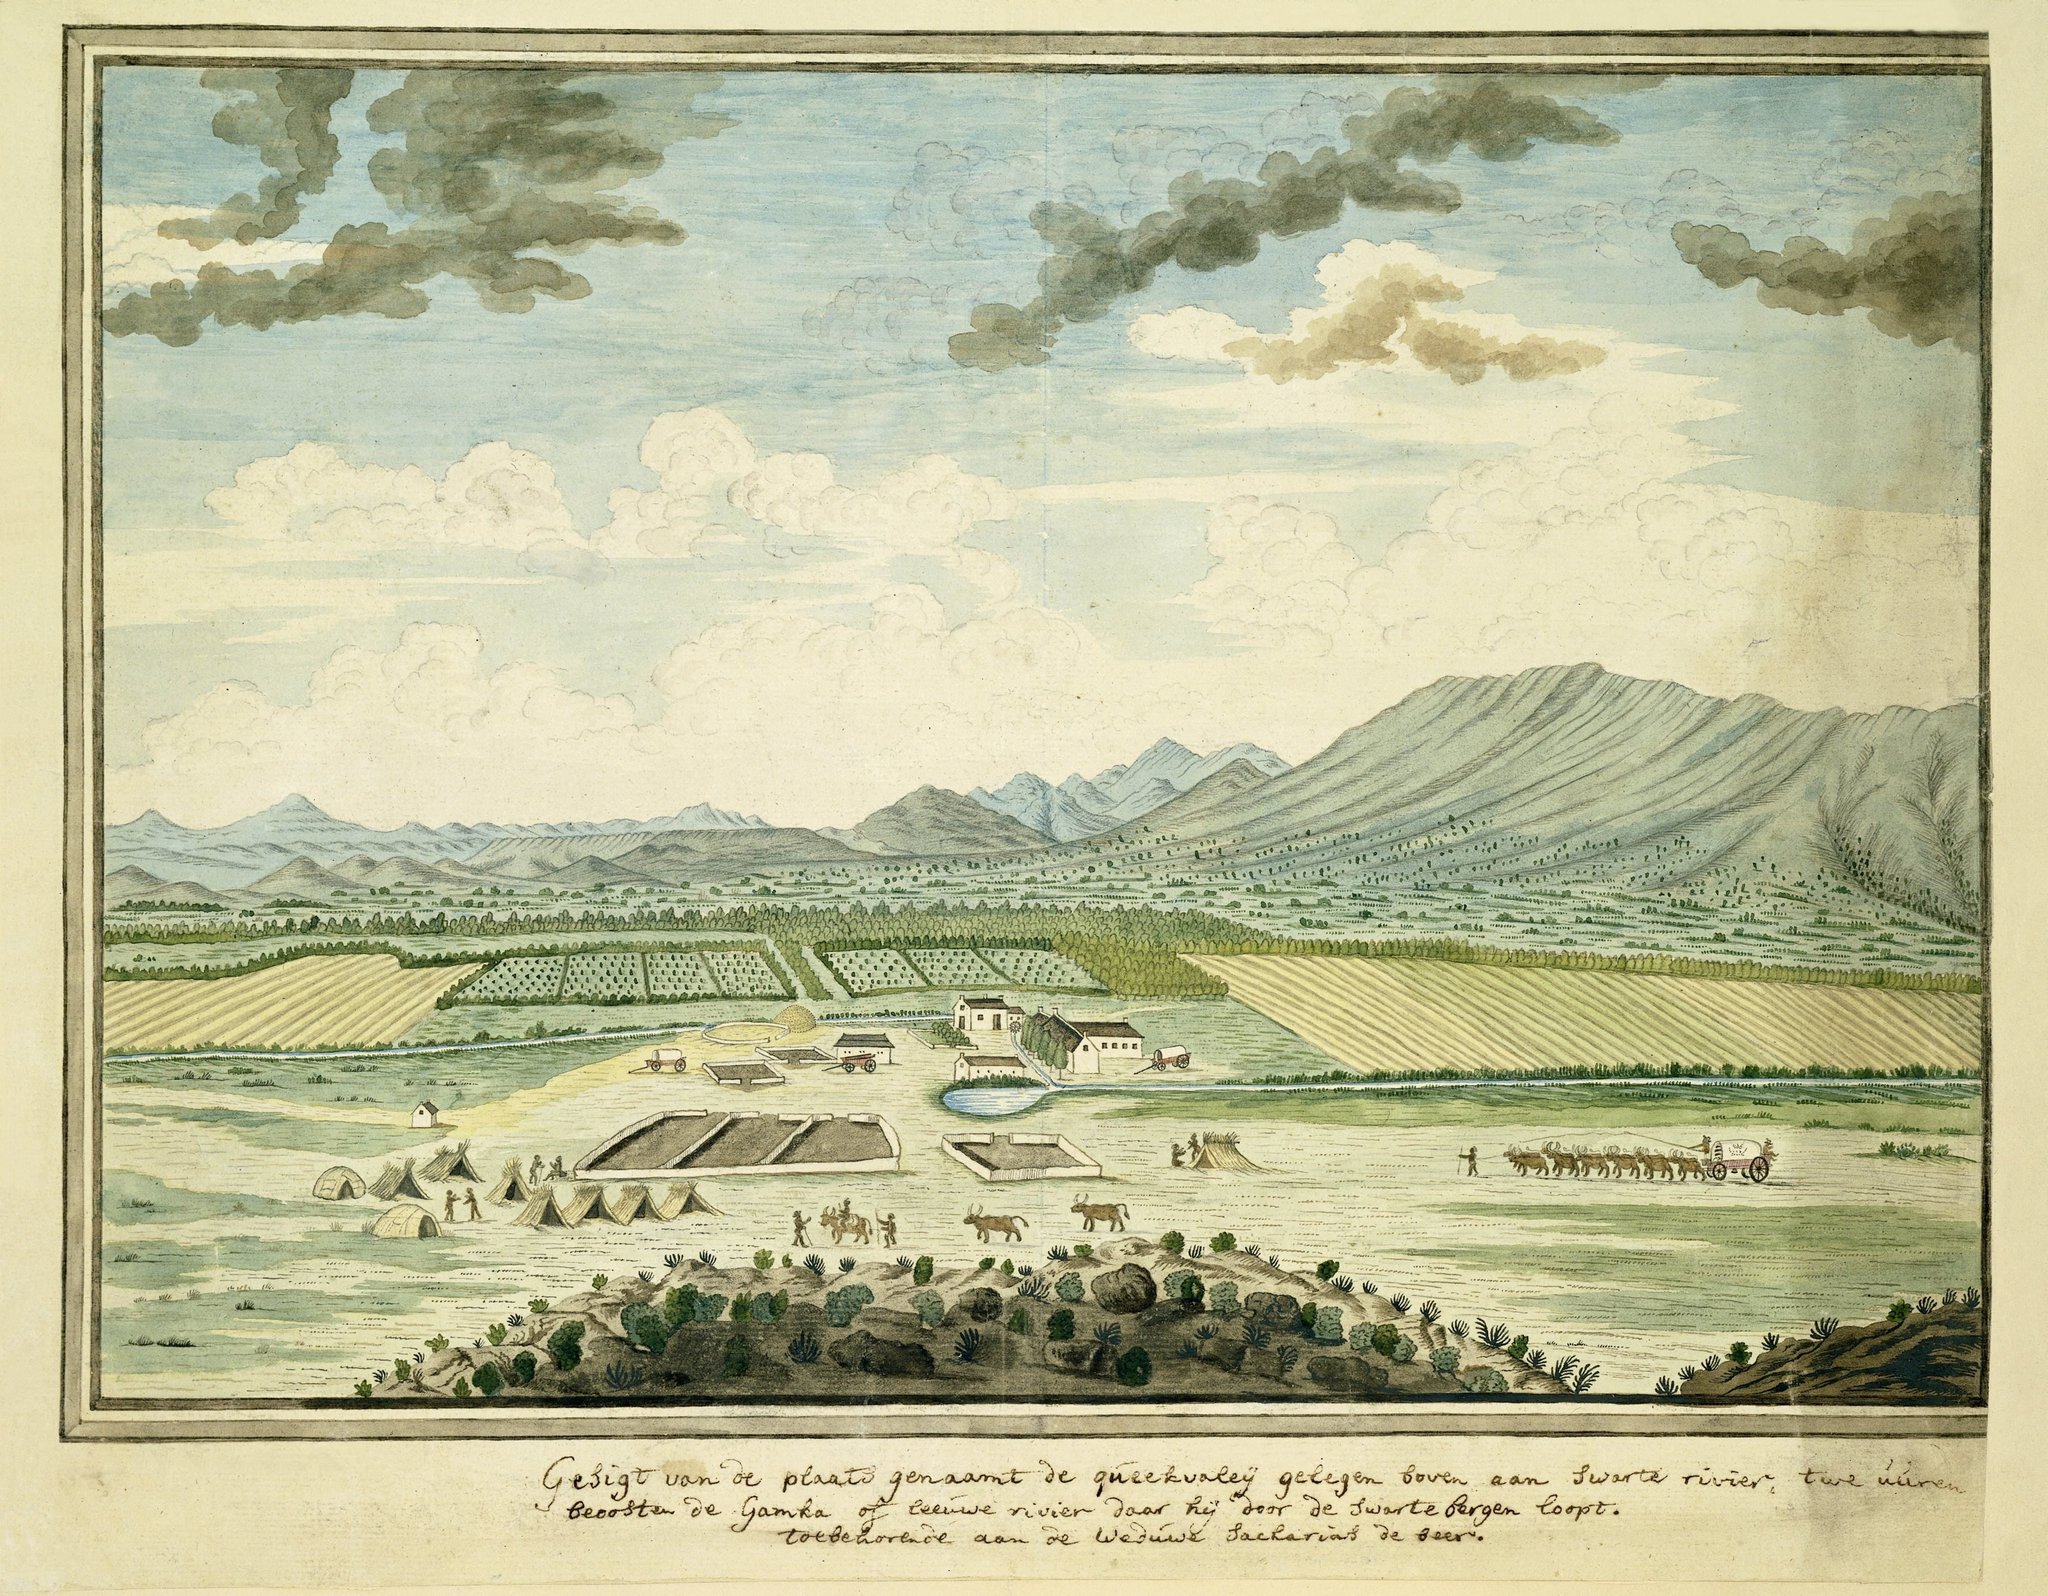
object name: drawing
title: Kweekvlei,the stock-farm of the widow of Zacharias de Beer, east of the Gamka river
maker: robert jacob gordon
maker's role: draughtsman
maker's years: 1743-1795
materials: ink, paper, pencil, watercolor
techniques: brush, pen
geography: cape province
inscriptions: annotation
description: Oorspronkelijk in omslag van roodkleurig halfleer en roodgemarmerd plat, dorso met ribben en goudopdruk; 71 x 99 x 6 cm.